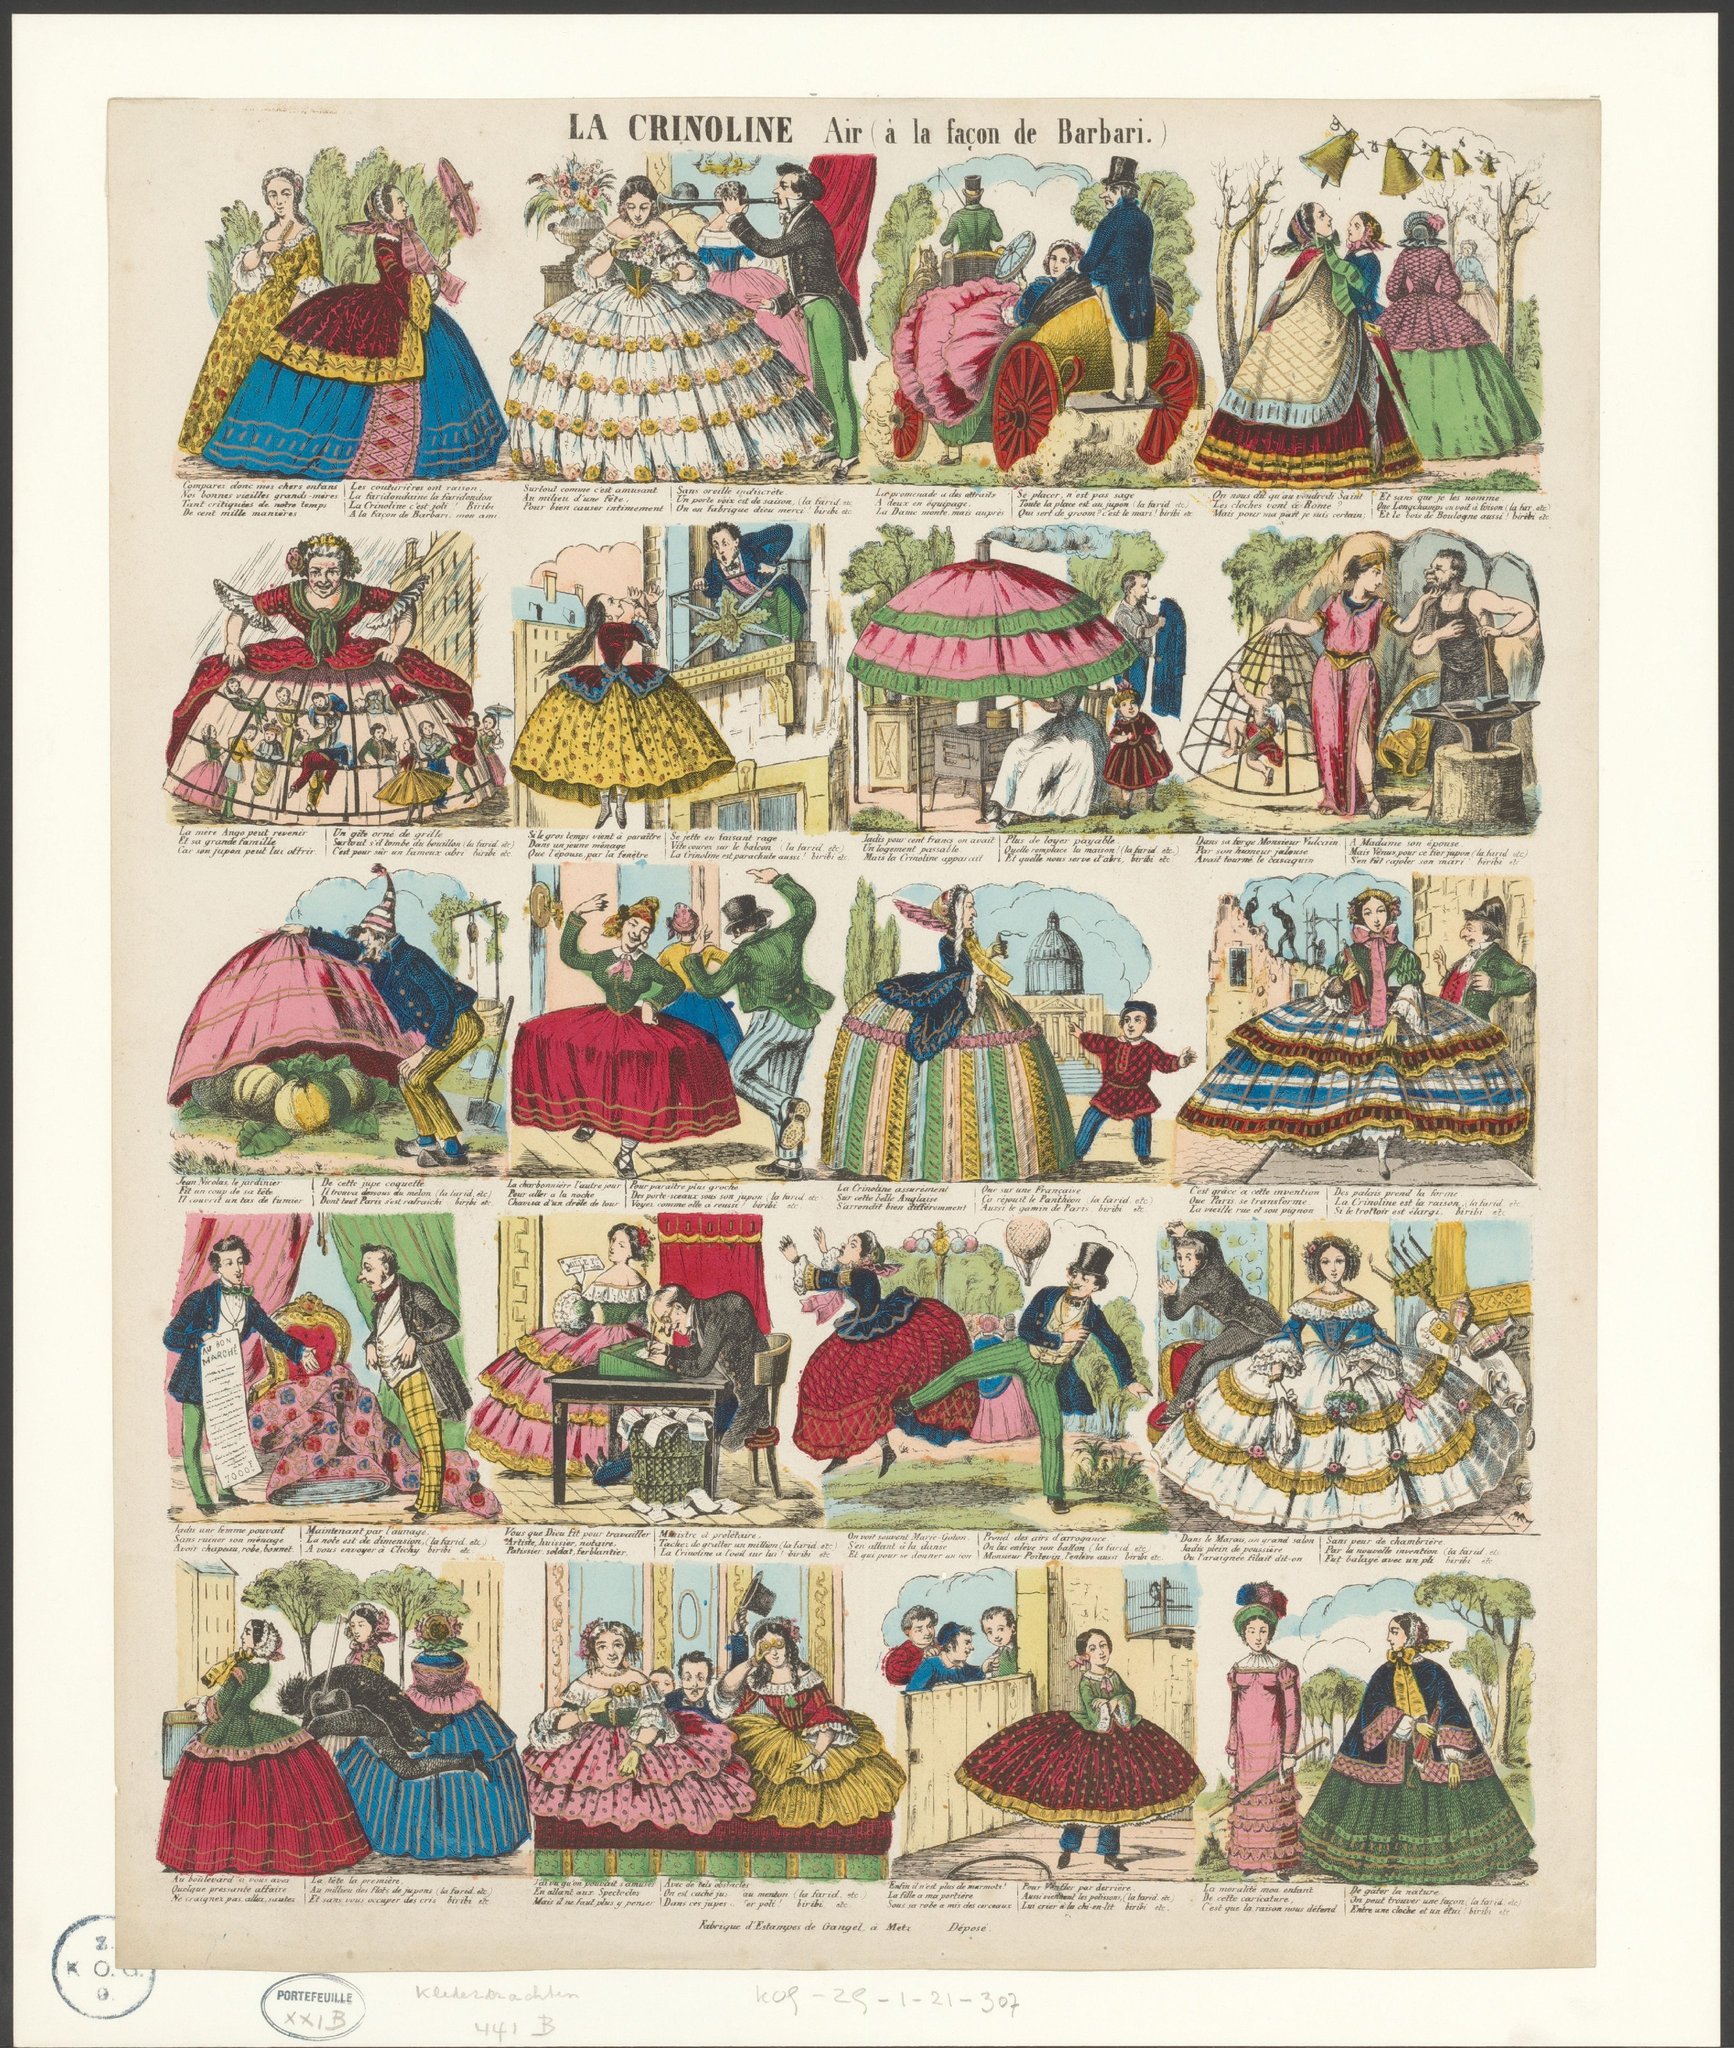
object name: popular print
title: Hoepelrokken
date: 1840-1879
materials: paint, paper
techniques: hand coloring, lithograph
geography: metz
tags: skirt (crinoline skirt) (+ women's clothes)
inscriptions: collector's mark: Lugt 1641, stamp, : ‘Déposé’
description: Volksprent met alle voor- en nadelen van de hoepelrok of crinoline. De rokken van vrouwen hadden een wijde omtrek wat voor veel onhandigheden zorgde. Maar er wordt ook een tuinman afgebeeld die de pompoenen afschermt met een crinoline. Onderwerpsrubrieken binnen de Atlas Zeden en Gewoonten: Zeden en Gewoonten in Engeren Zin, De Kleeding, Kleederdrachten (tijdvakken), De crinolinetijd.